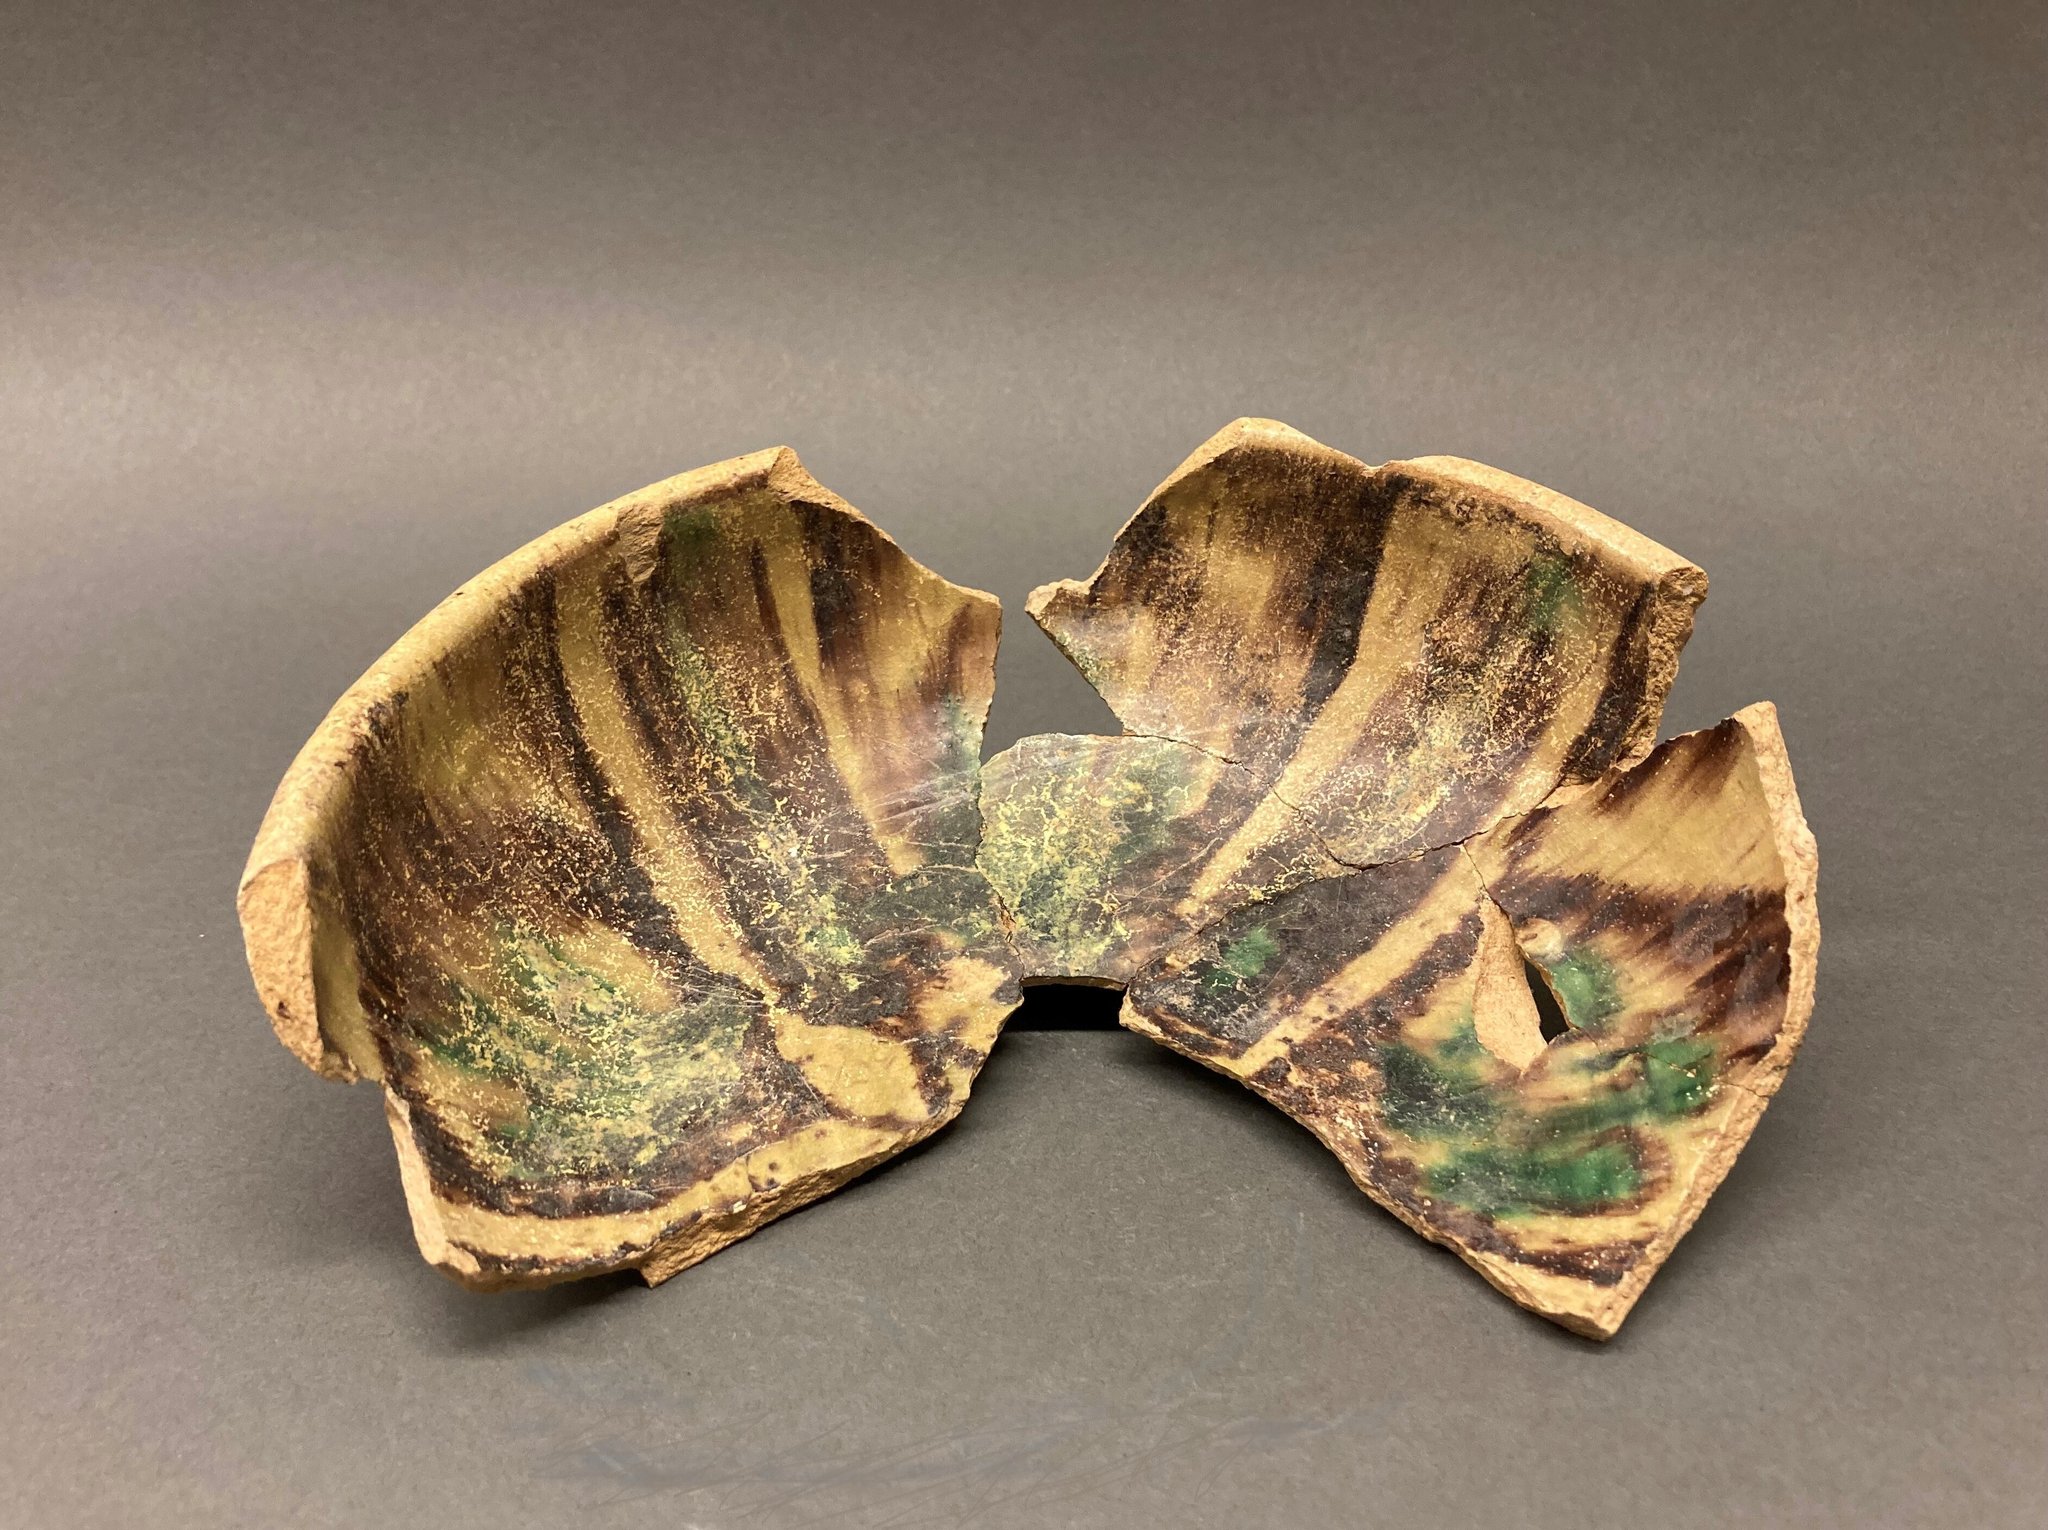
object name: bowl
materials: earthenware, glaze, pigment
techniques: painting, polychrome, underglaze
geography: iran